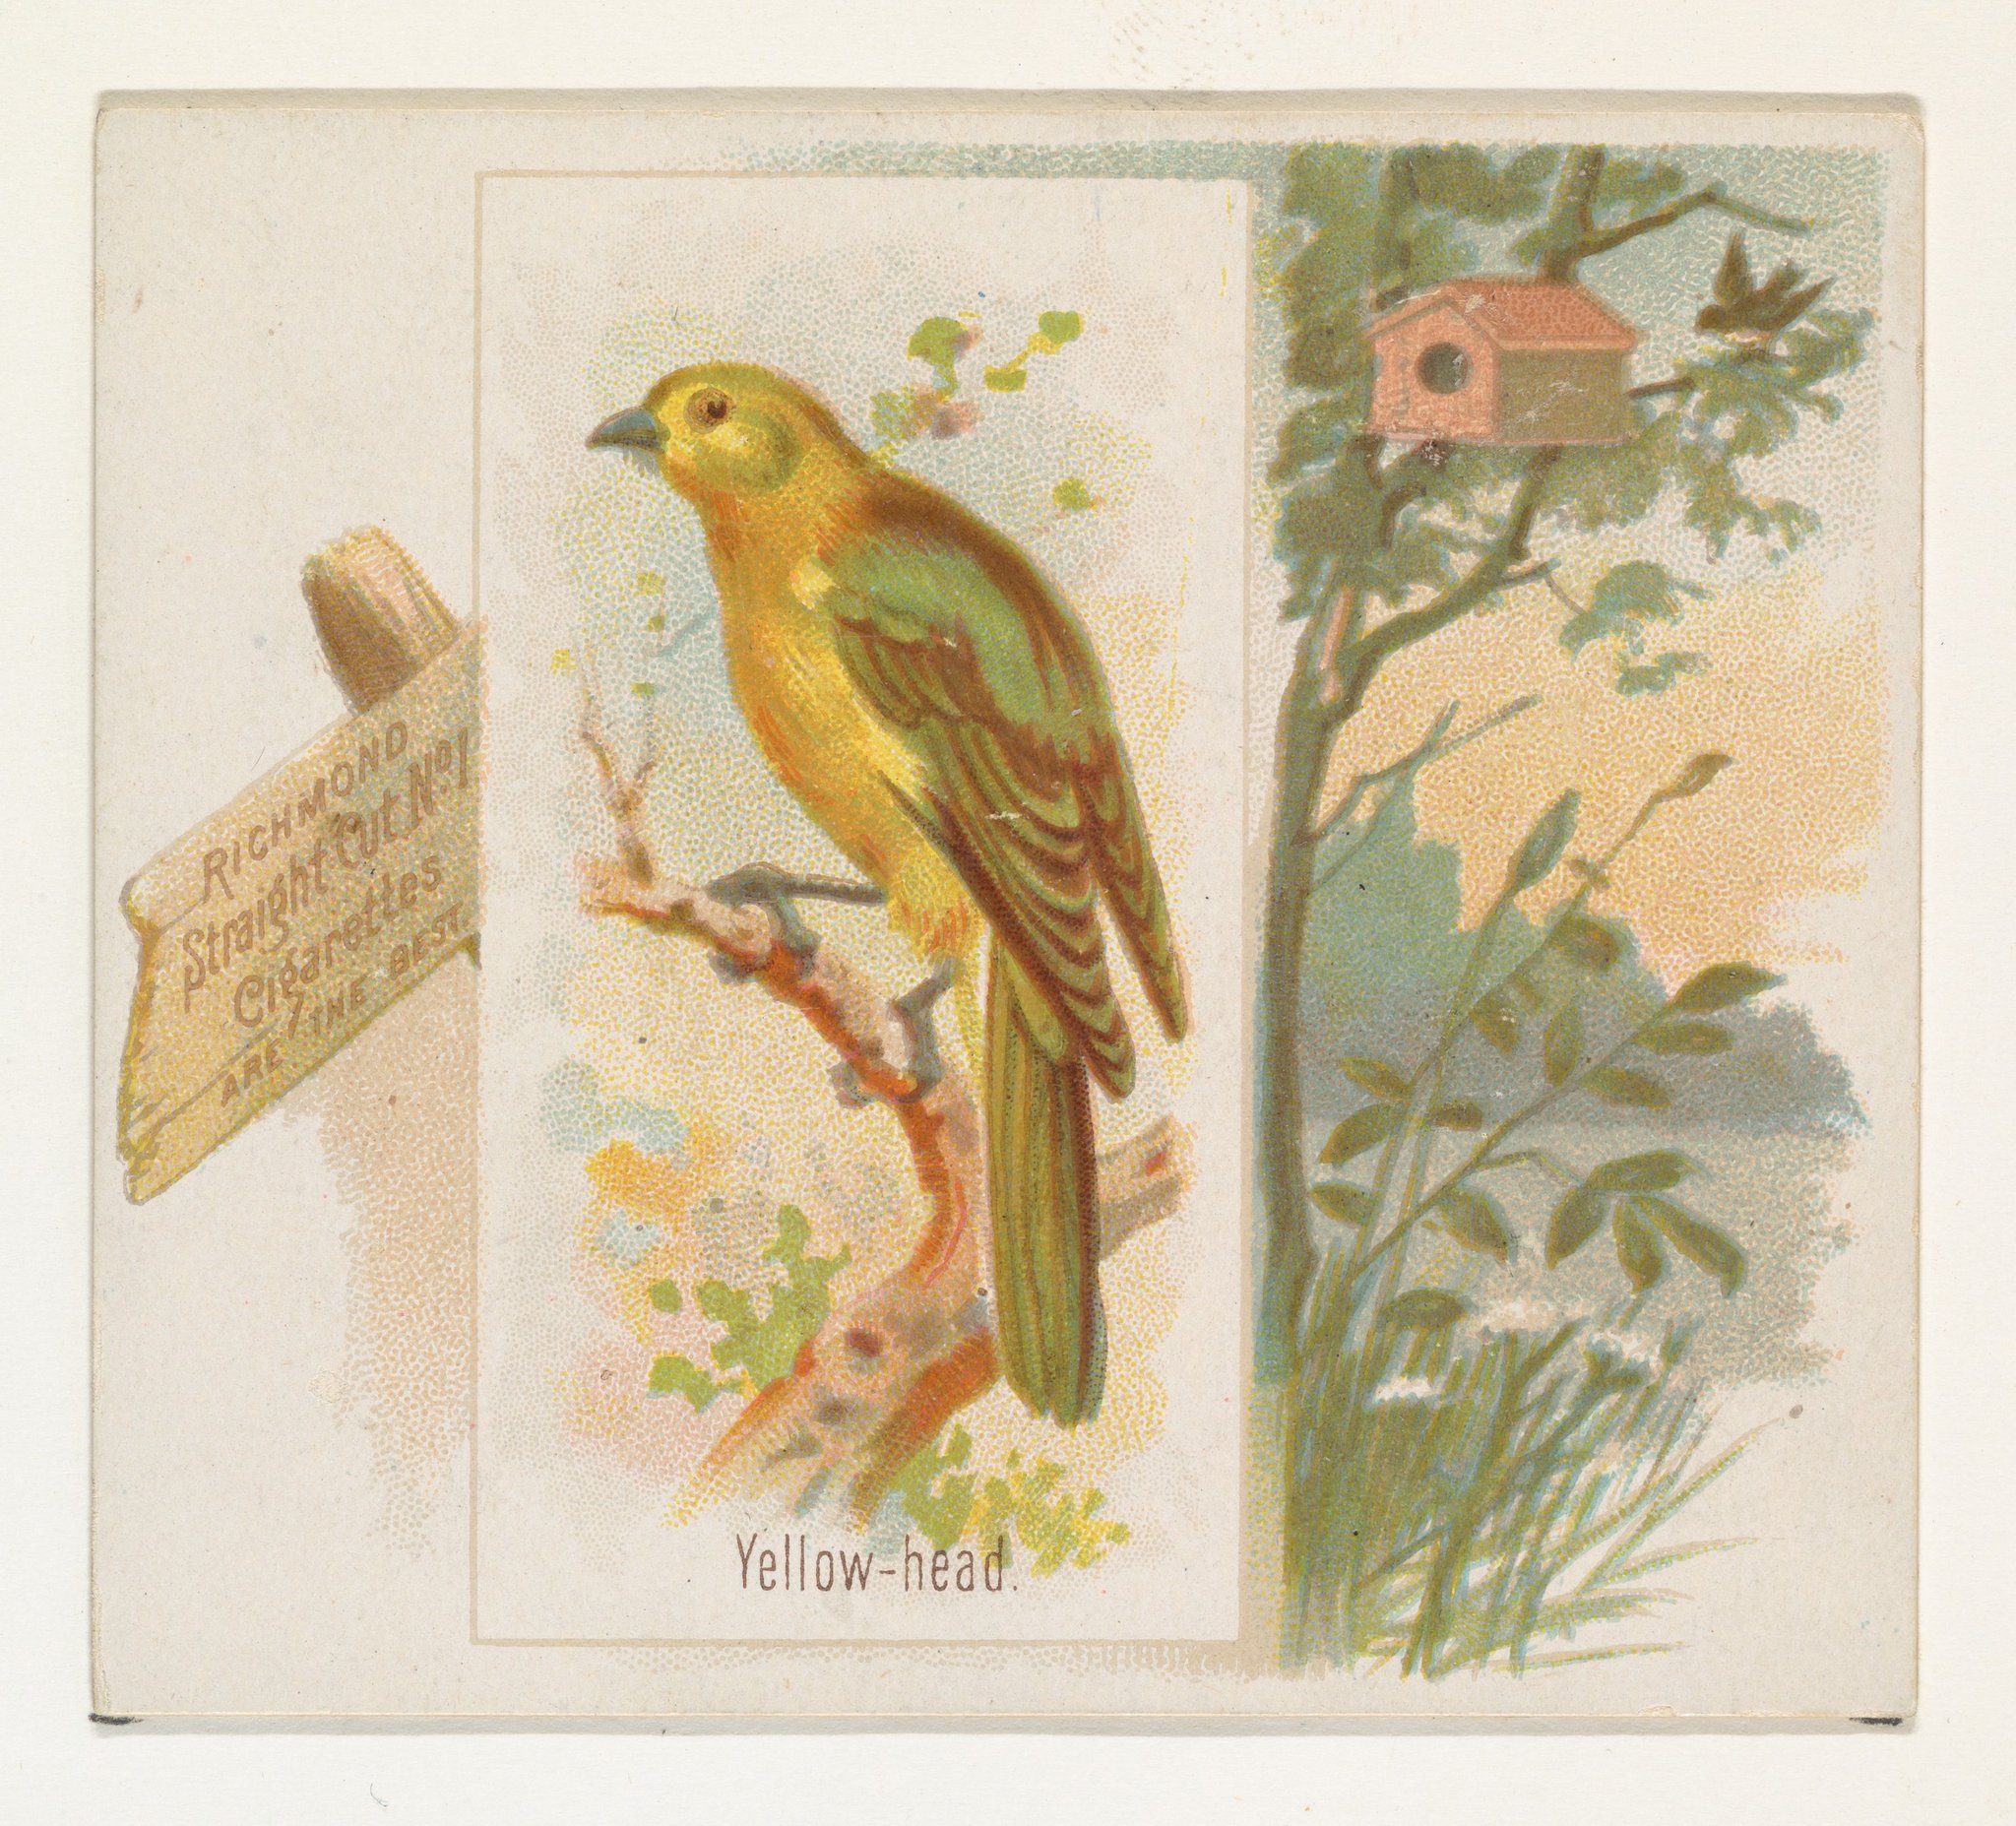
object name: print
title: Yellow-head, from the Song Birds of the World series (N42) for Allen & Ginter Cigarettes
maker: allen & ginter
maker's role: publisher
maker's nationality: american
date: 1890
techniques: color lithograph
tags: birds